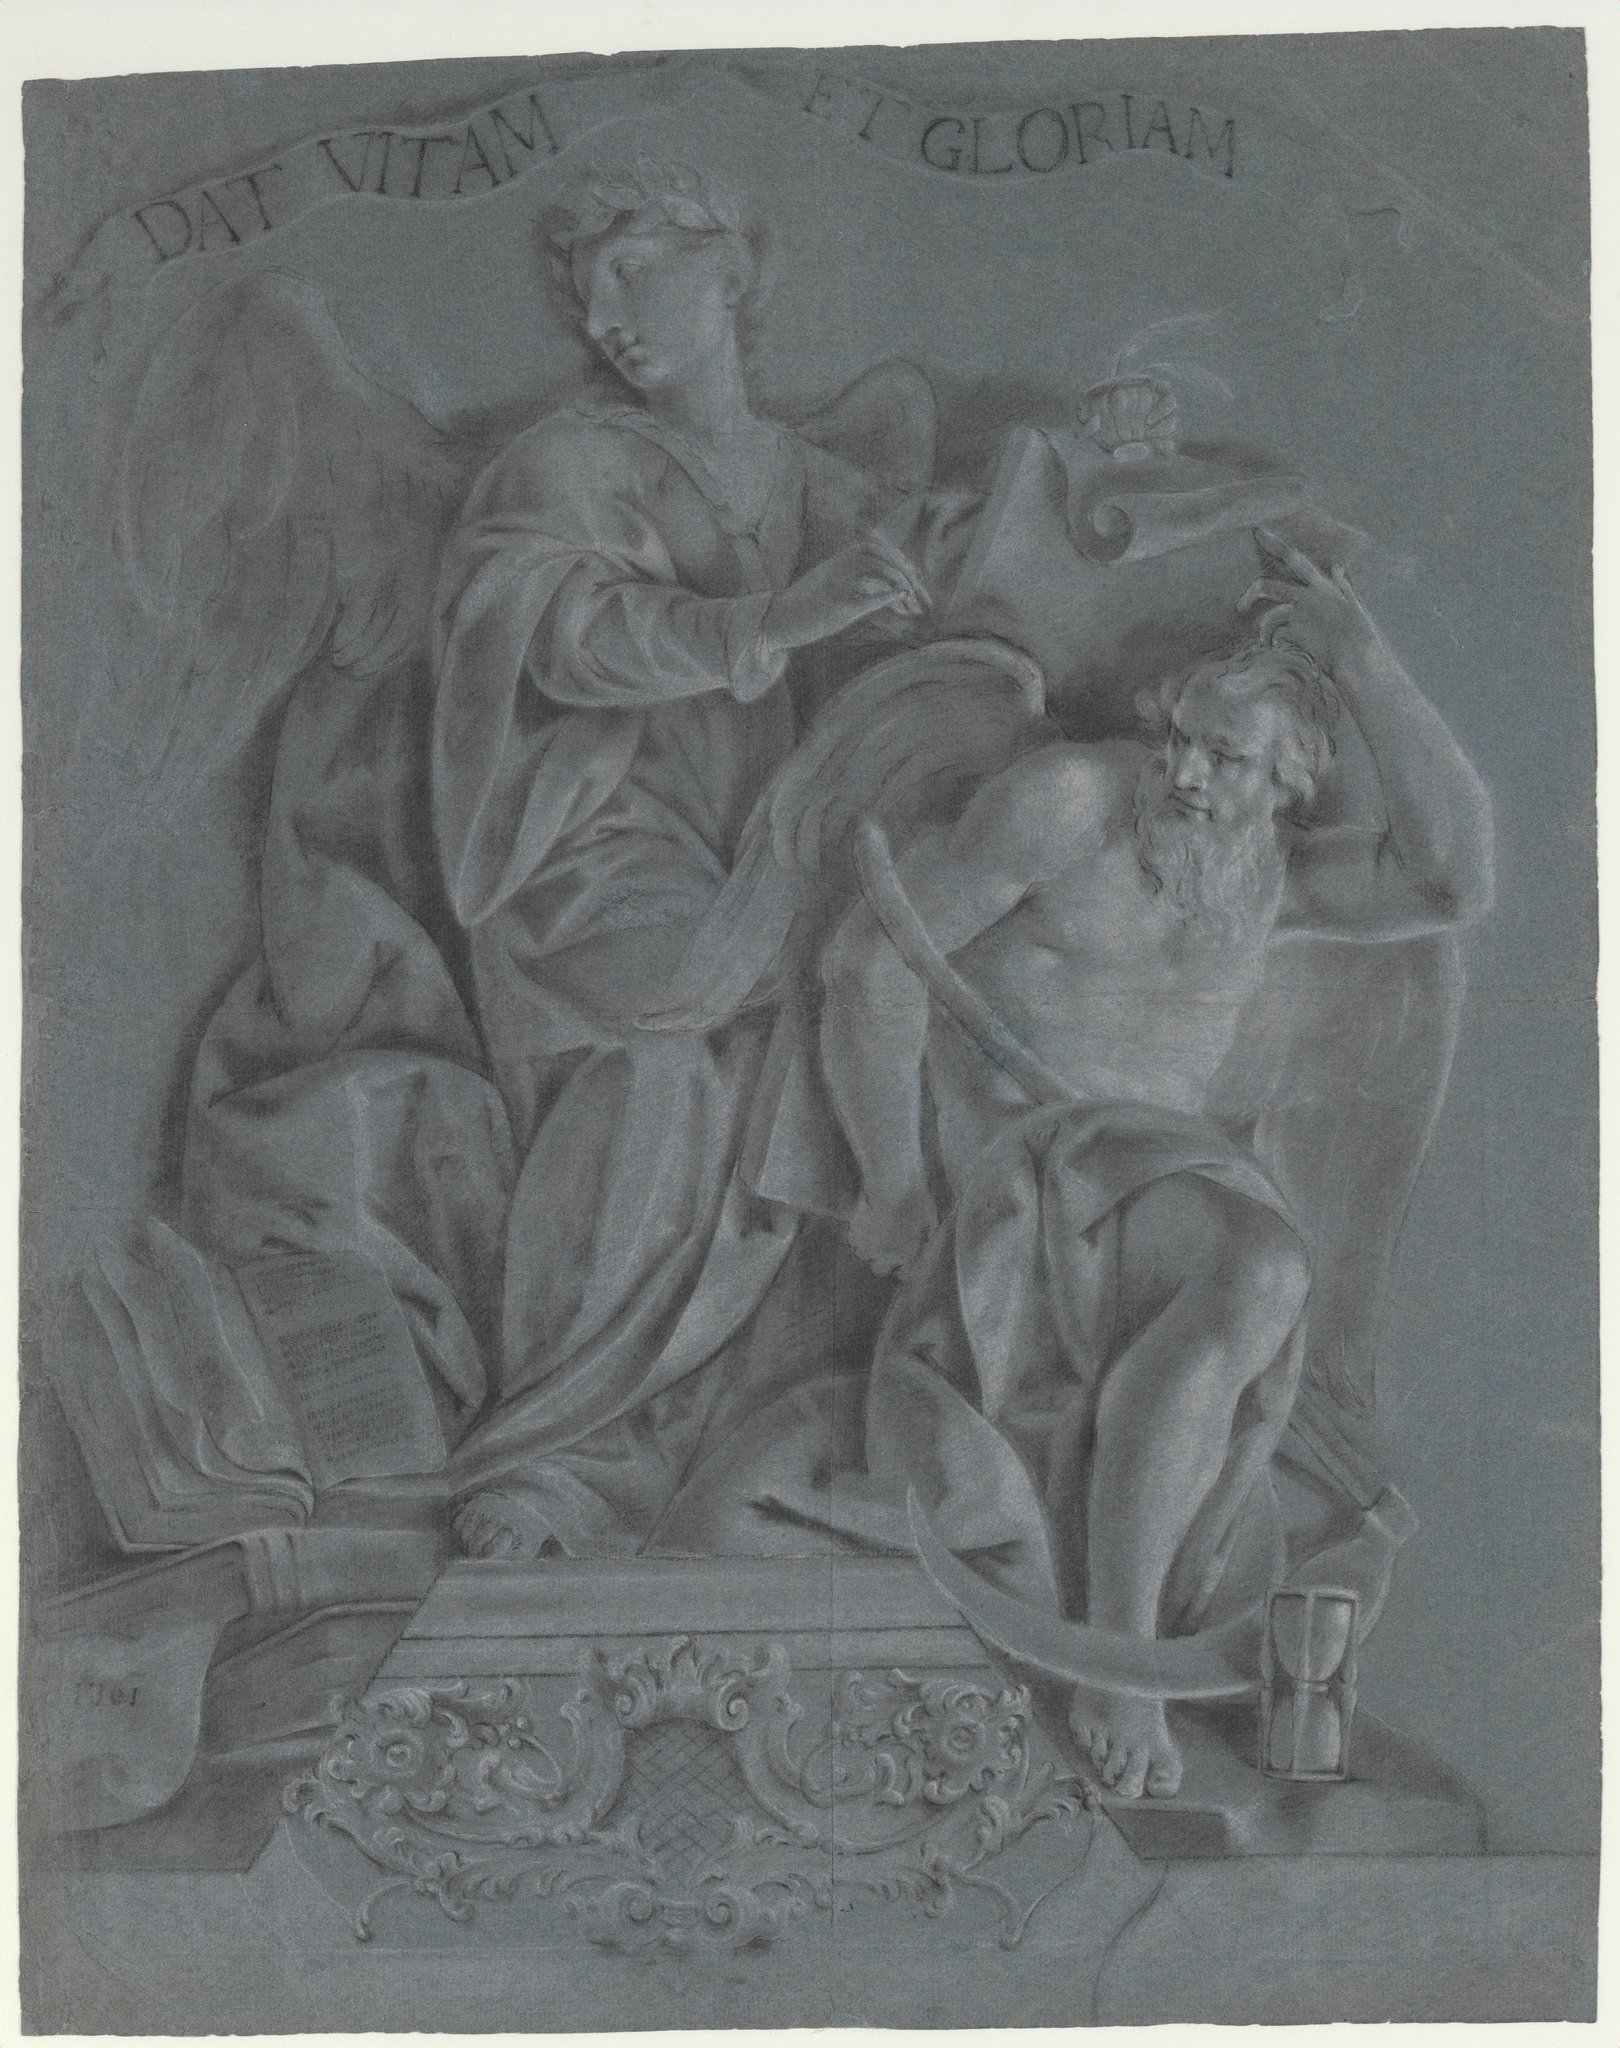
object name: drawing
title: Allegory of History, with Time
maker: vittorio maria bigari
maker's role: artist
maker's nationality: italian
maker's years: 1692-1776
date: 1761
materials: chalk, paper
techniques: highlighting, stumping